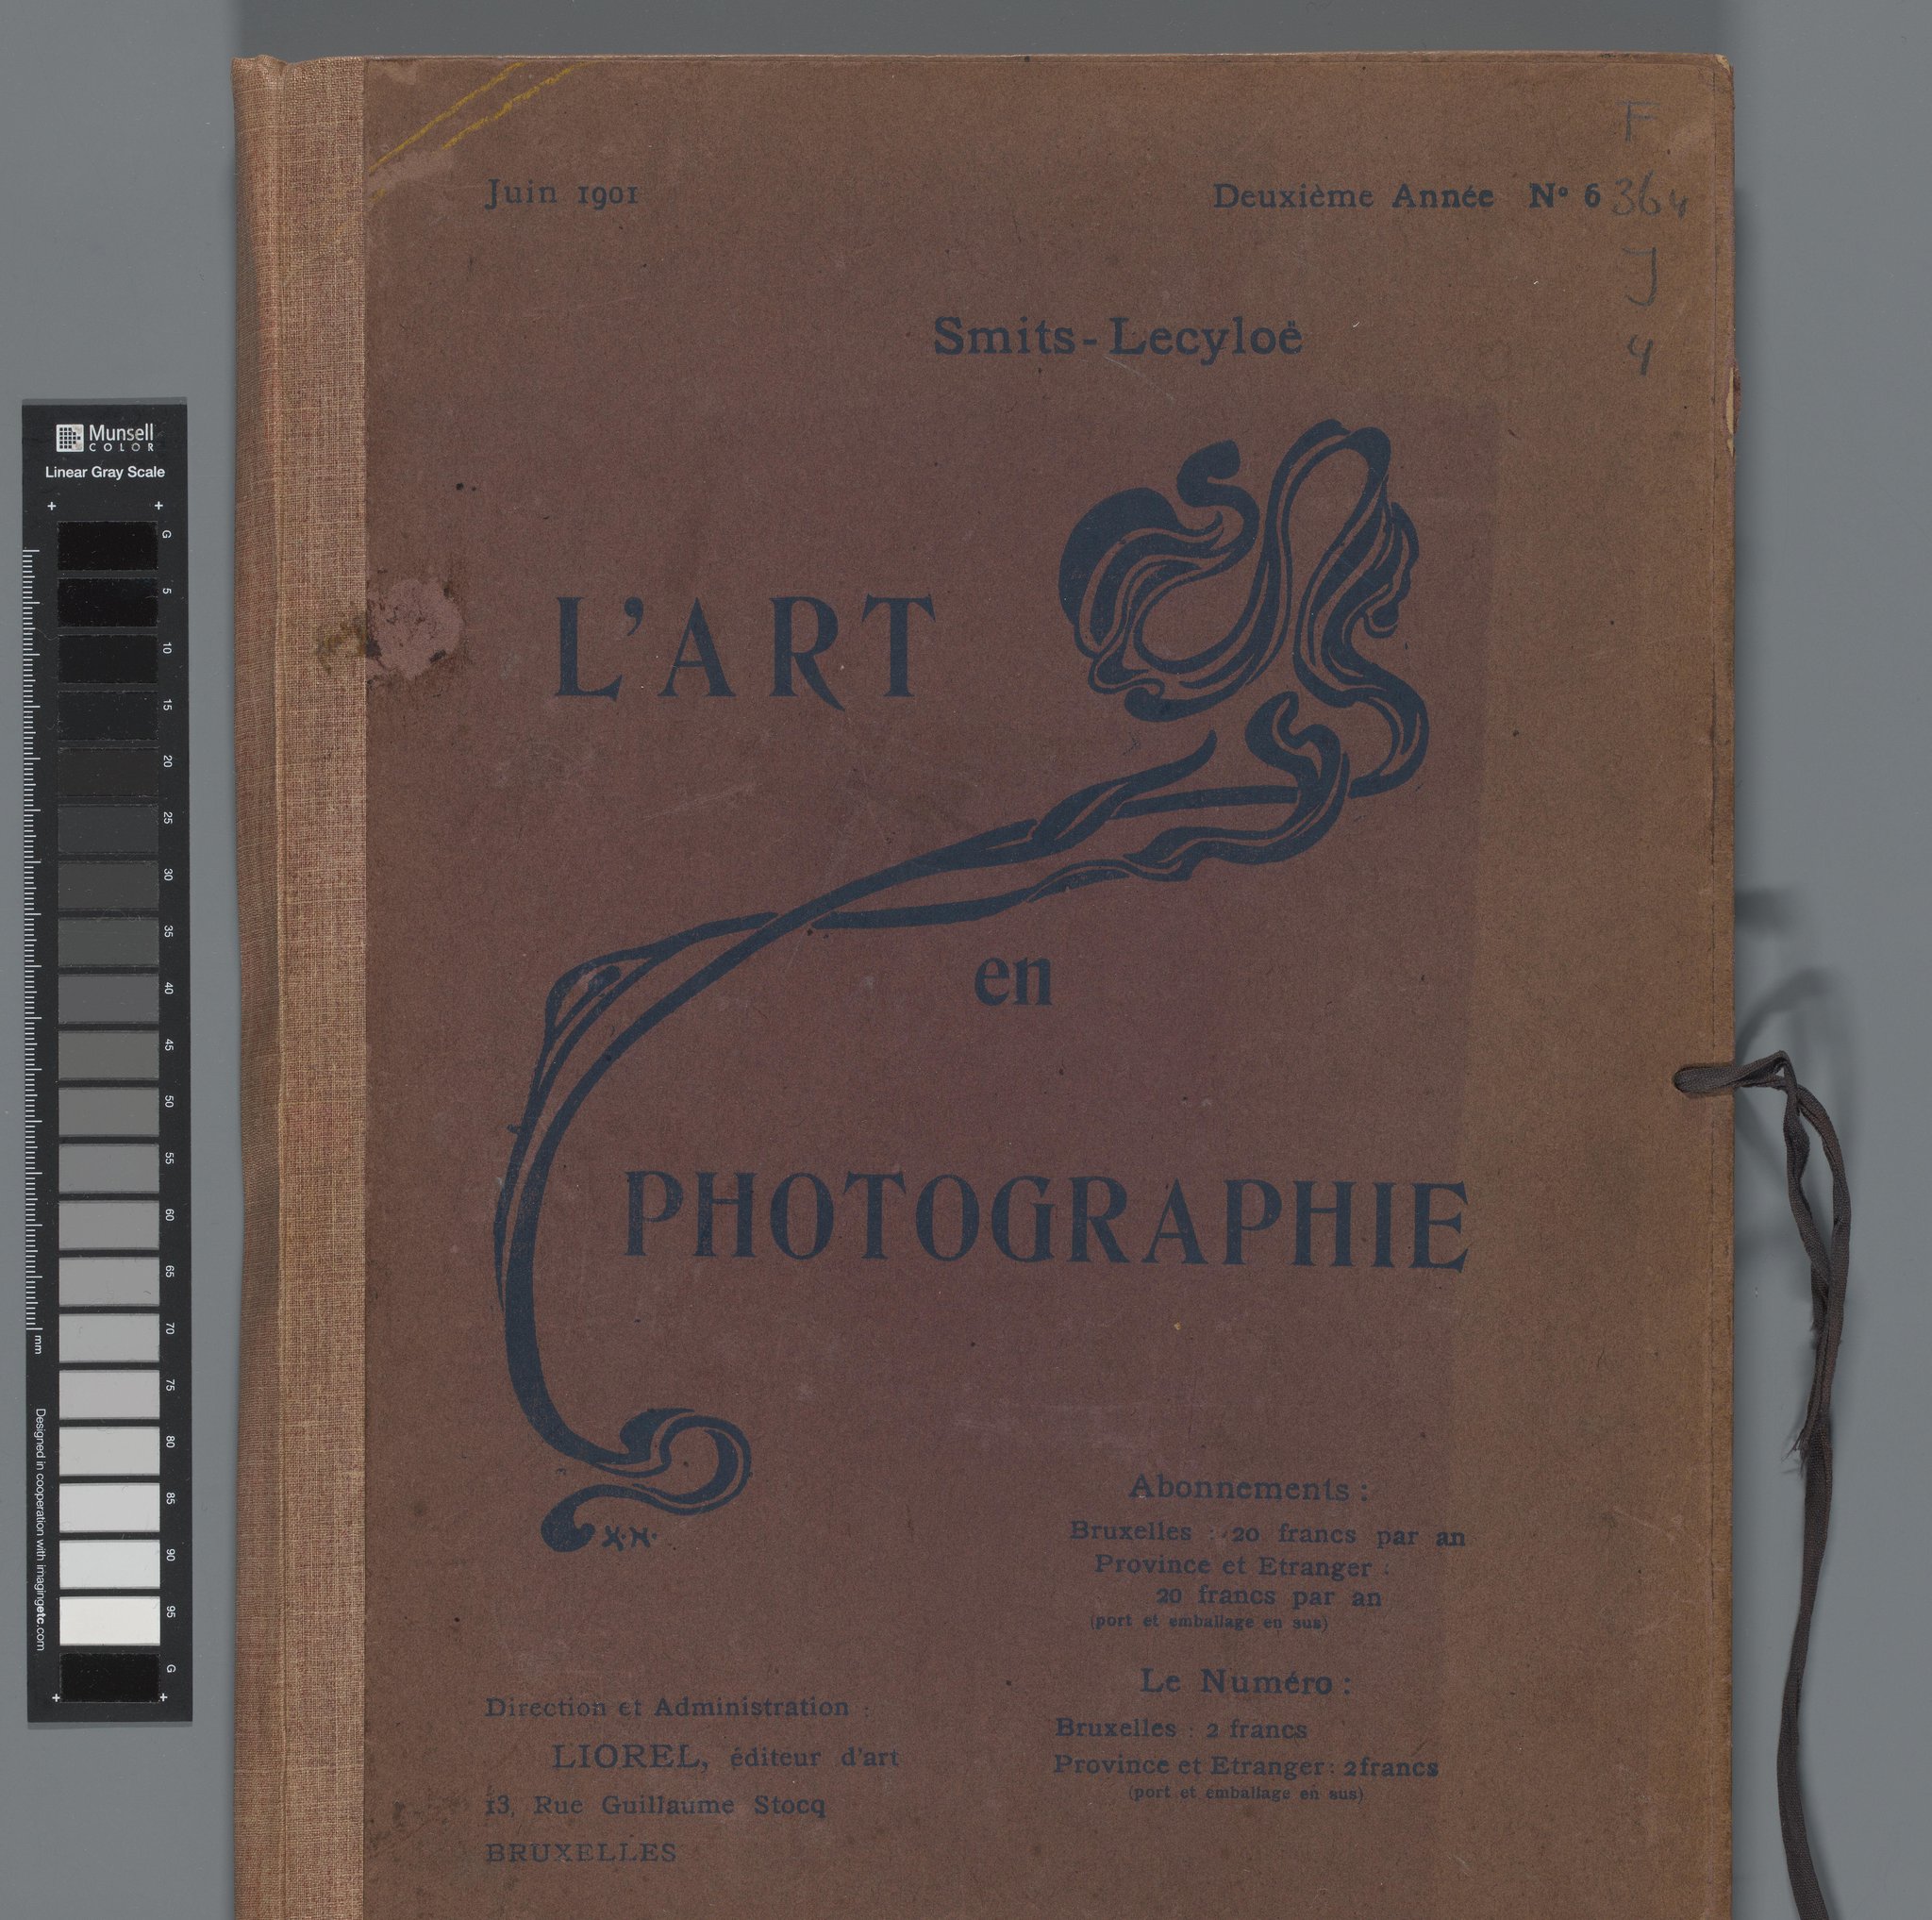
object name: wrapper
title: L'art en photographie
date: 1901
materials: paper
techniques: photograph, printing